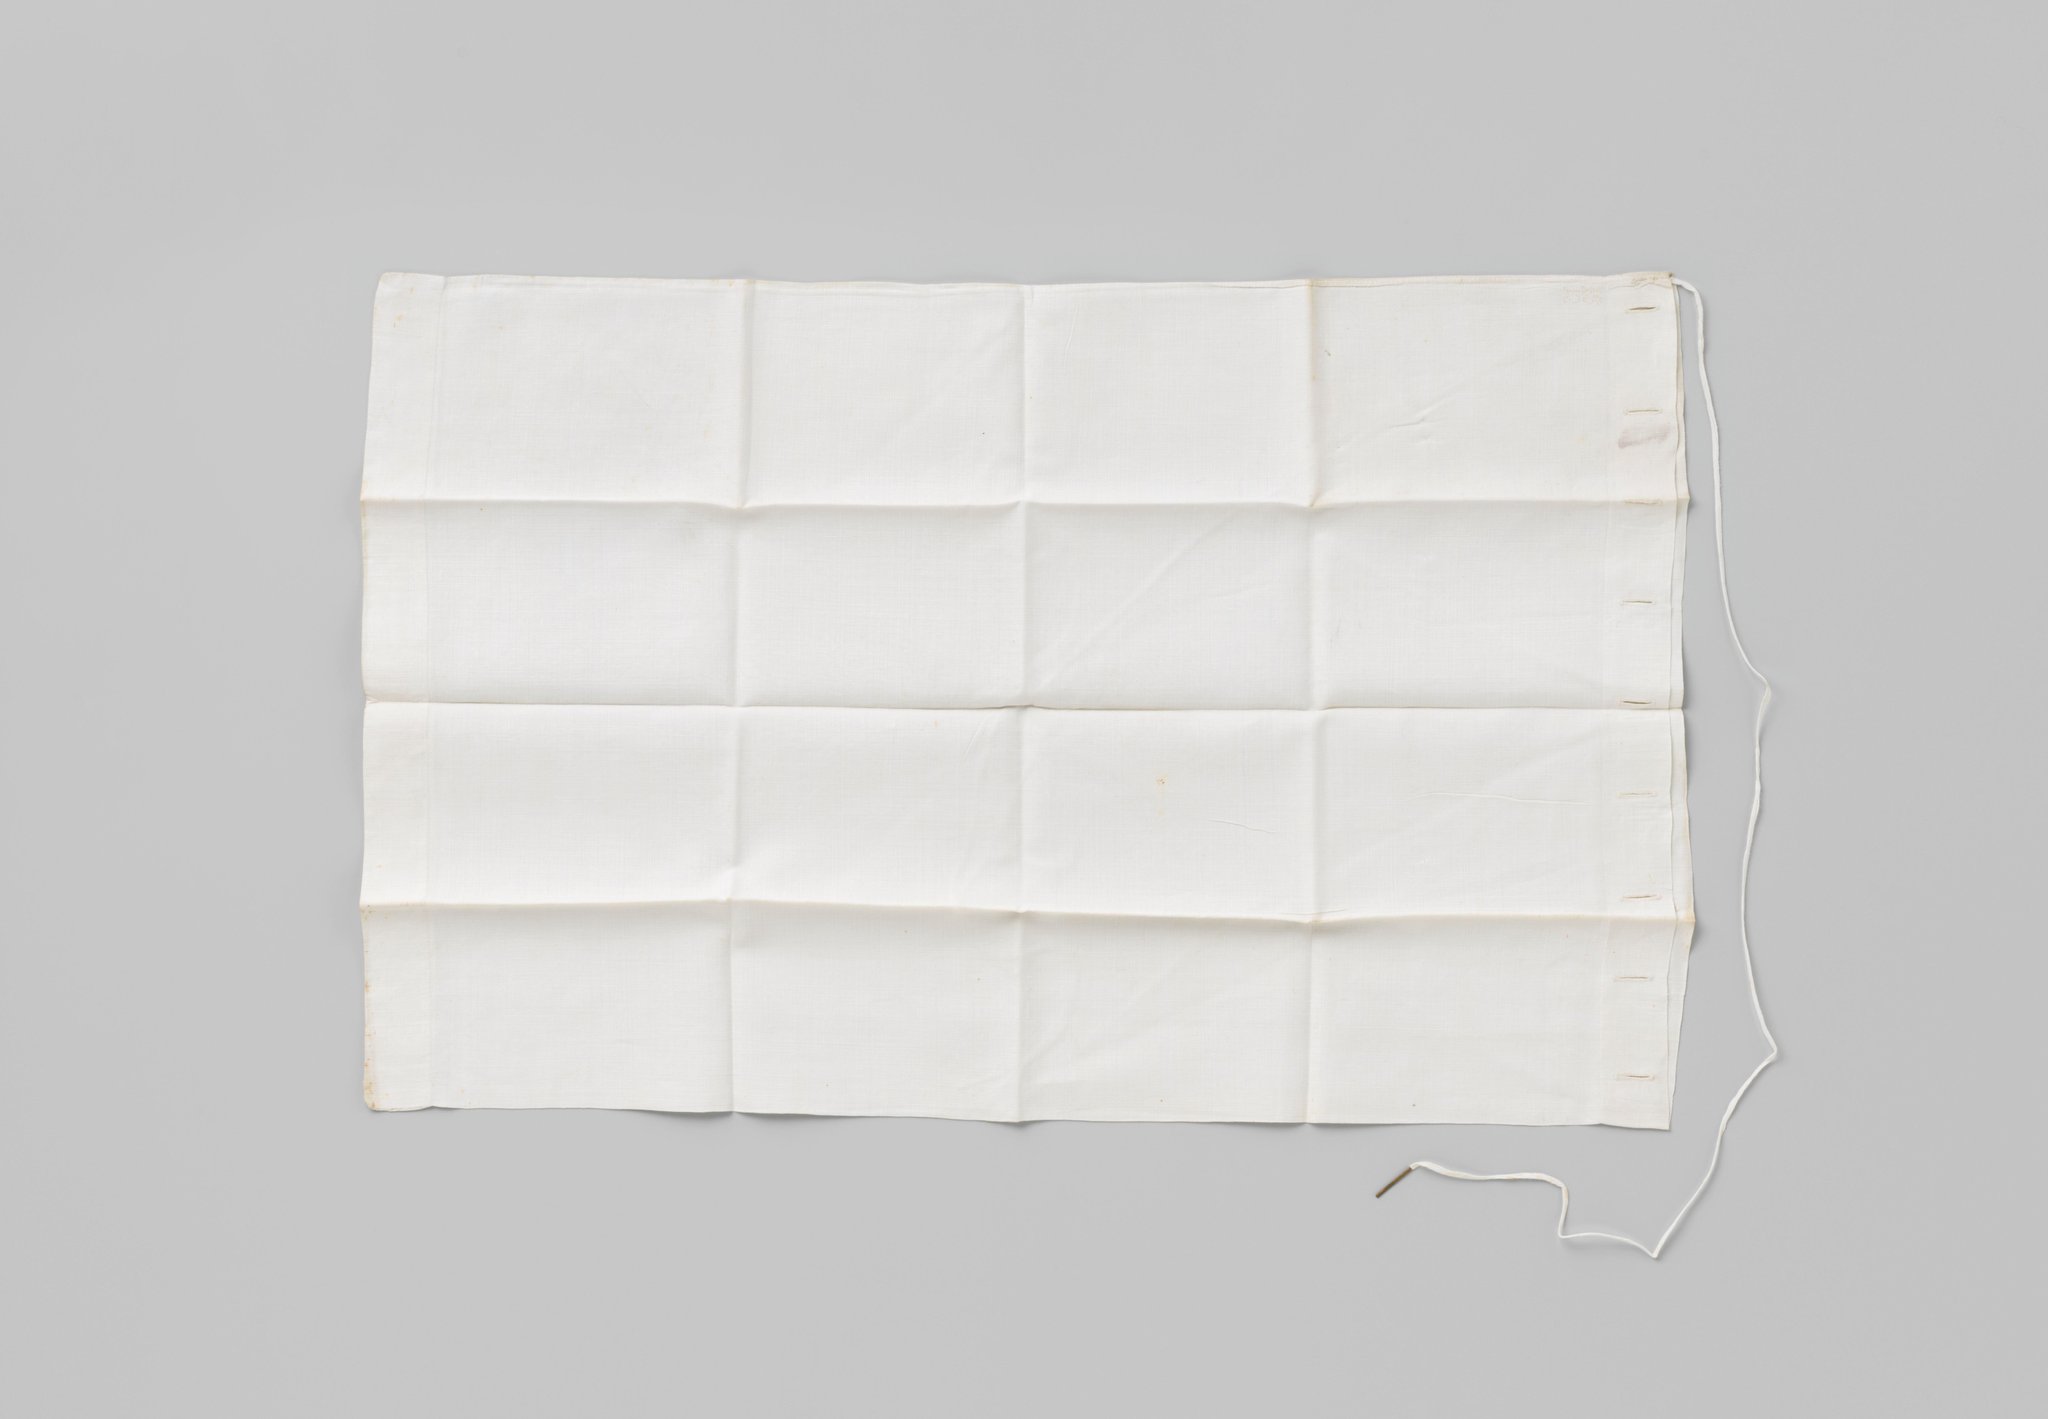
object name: lendensloop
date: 1760-1816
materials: linen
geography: northern netherlands